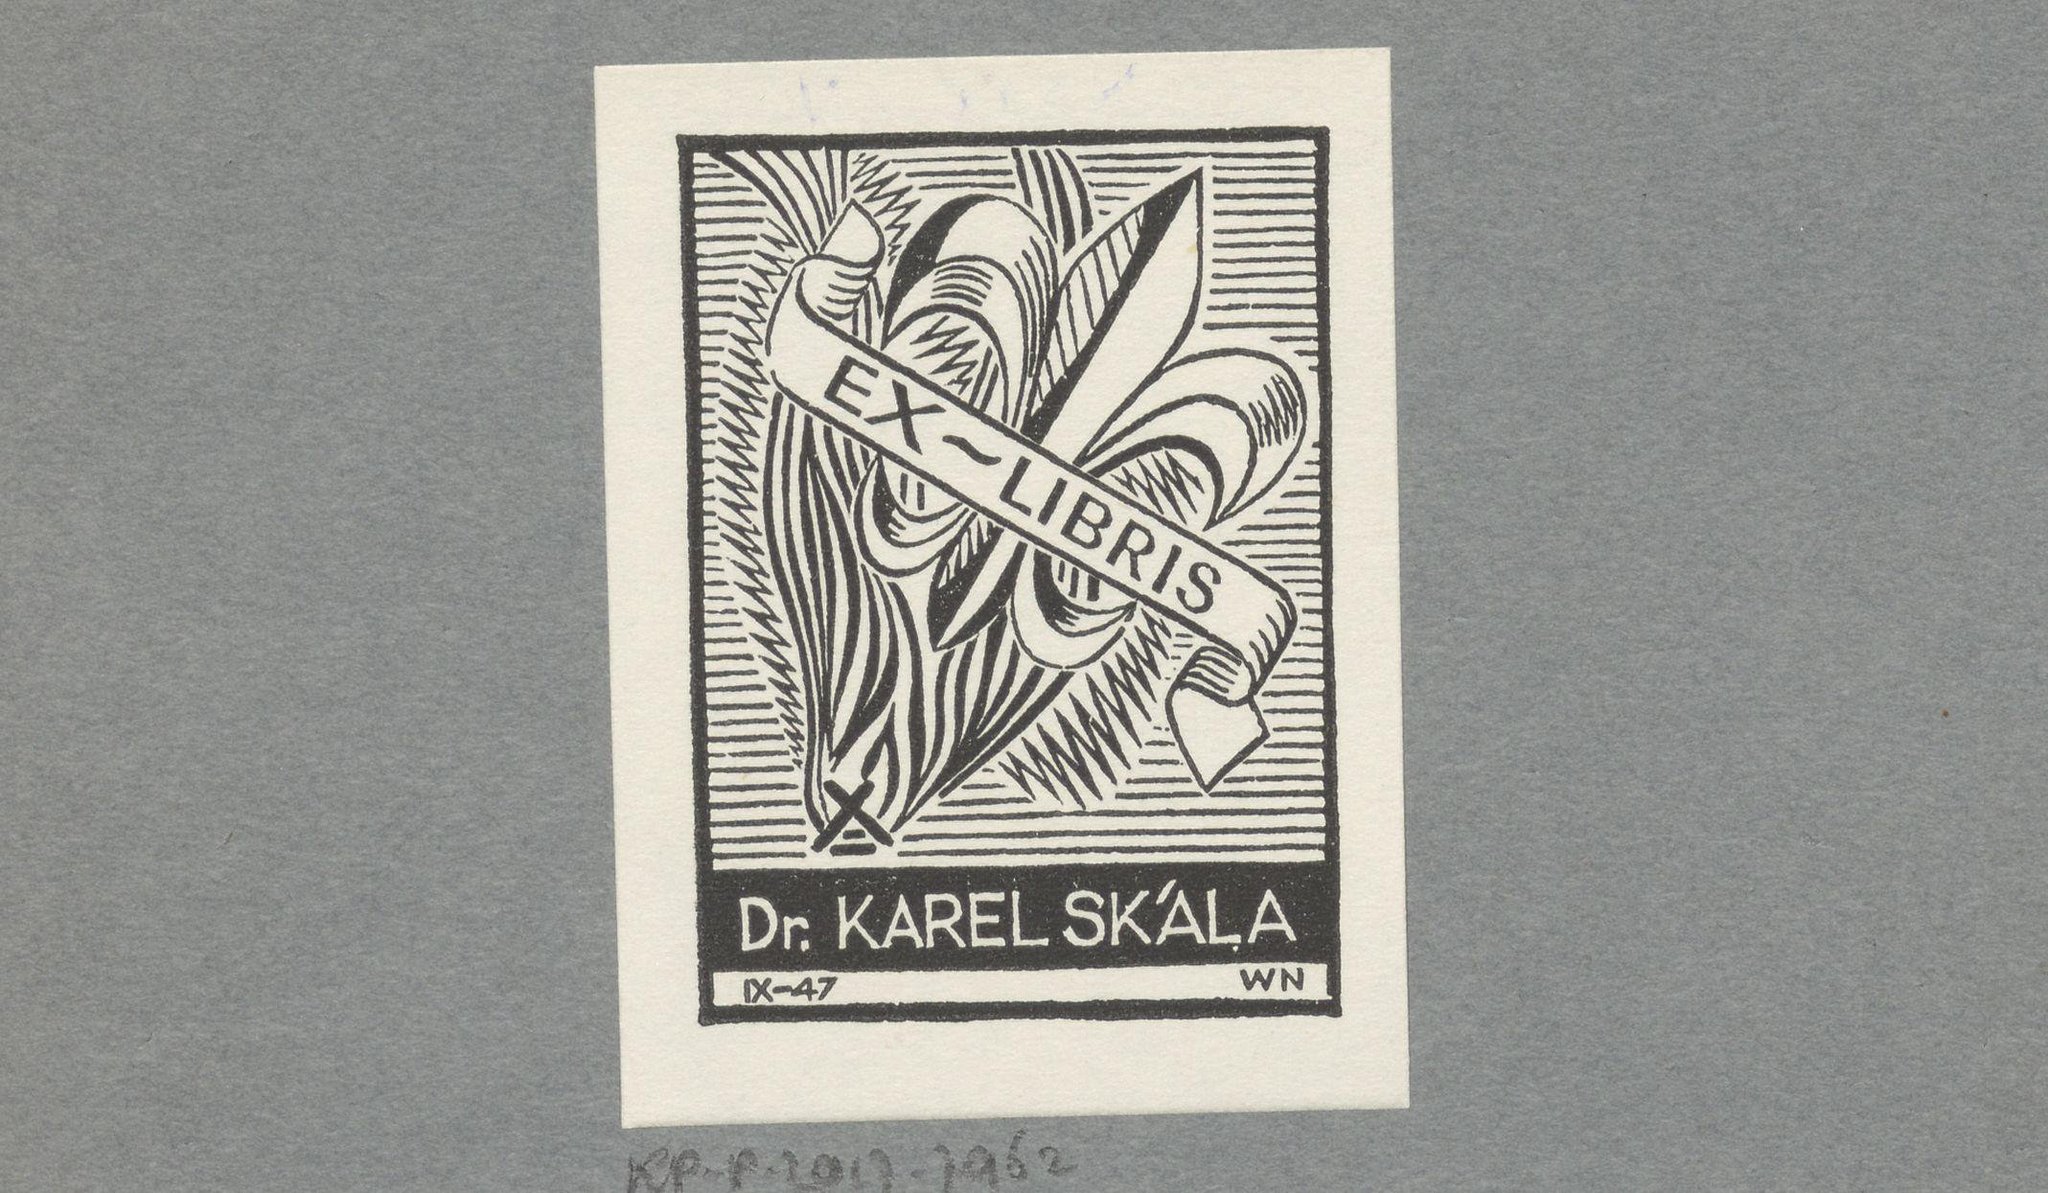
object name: bookplate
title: Ex libris van Karel Skála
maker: wojciech nowakowski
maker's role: print maker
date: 1948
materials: paper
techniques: linocut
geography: poland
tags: fleur-de-lis ~ ornament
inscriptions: inscription: ‘Wojciech Nowakowski sc 1948/ lino Polen/ (Äg.Tjechoslovakien)’